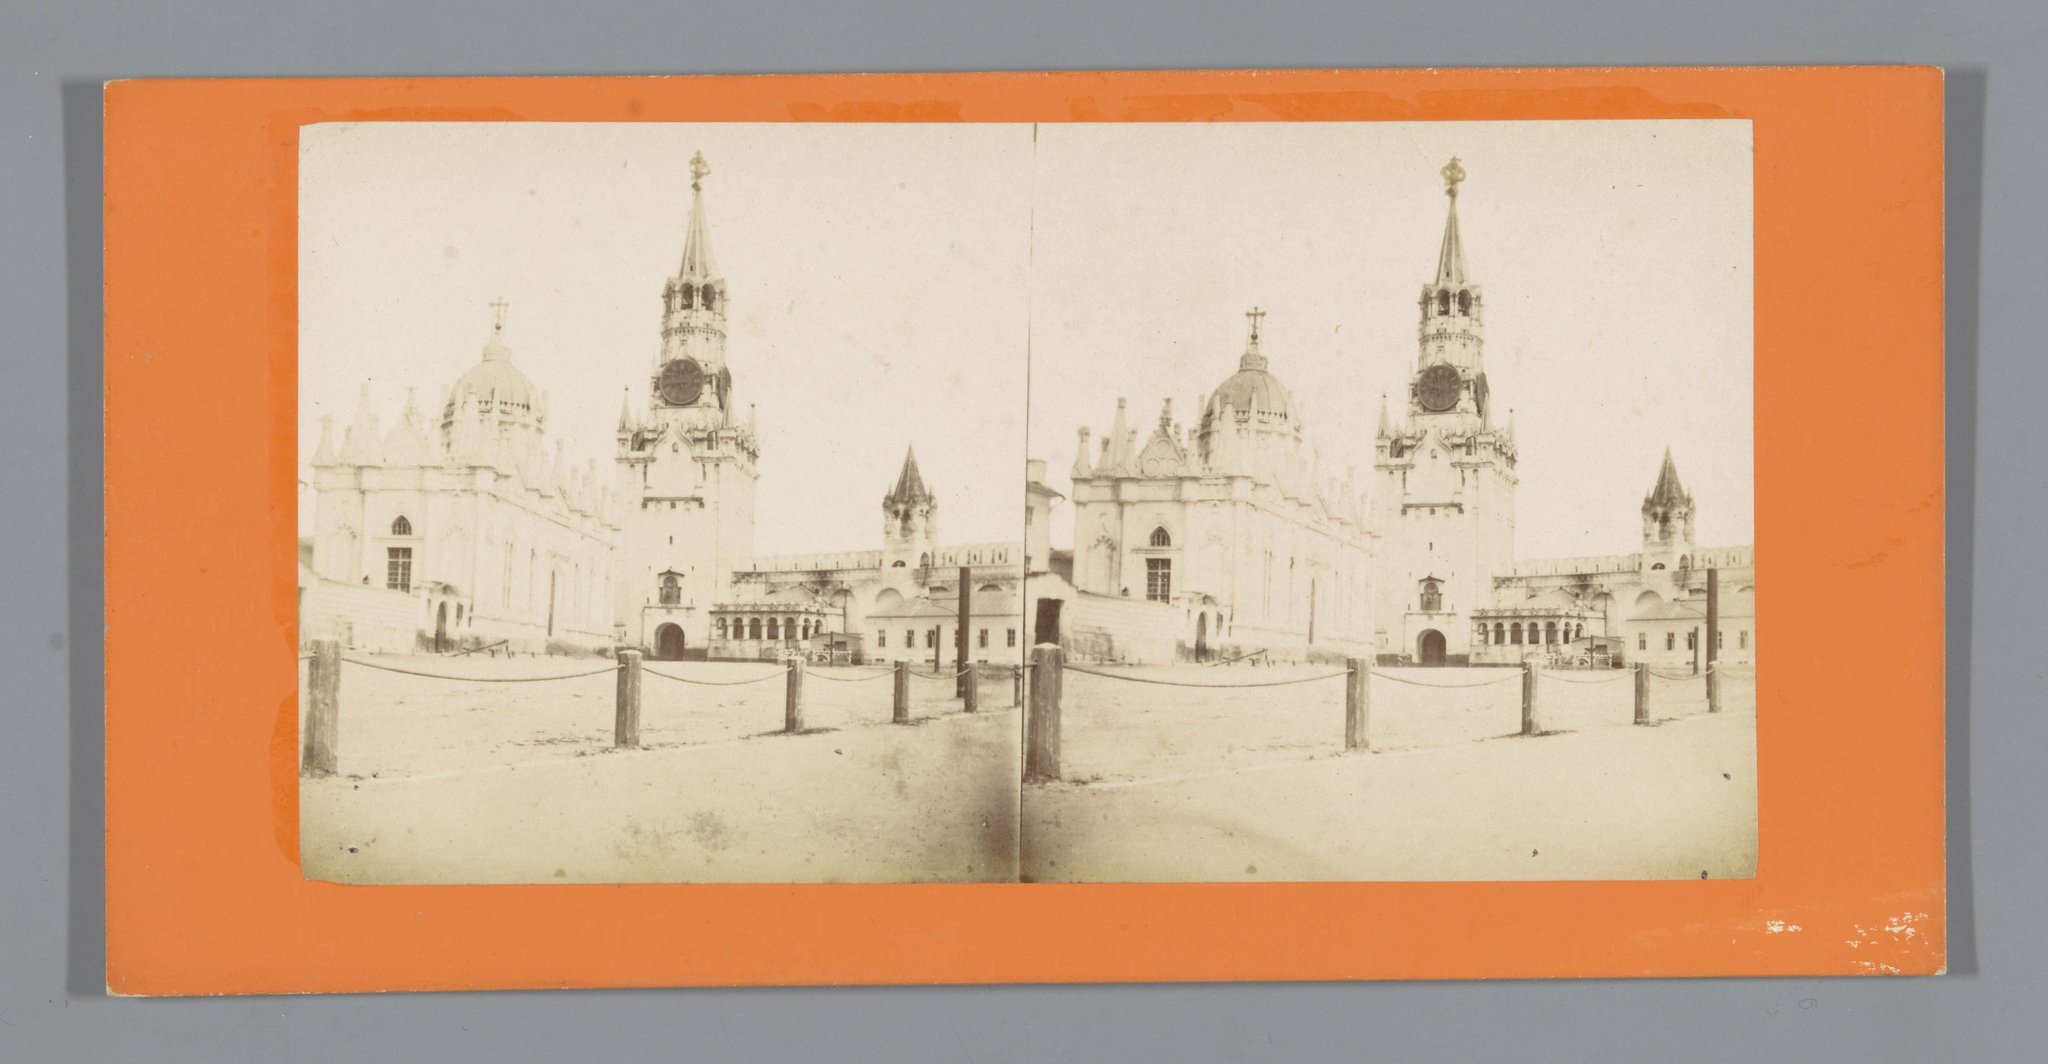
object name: stereograph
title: Gezicht op de Troitskayatoren in Moskou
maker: Anonymous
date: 1850-1880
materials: cardboard, photographic support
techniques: albumen print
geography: moscow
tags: tower, clock tower ~ monumental adornment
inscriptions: inscription: ‘49 La porte Sainte Moscou’